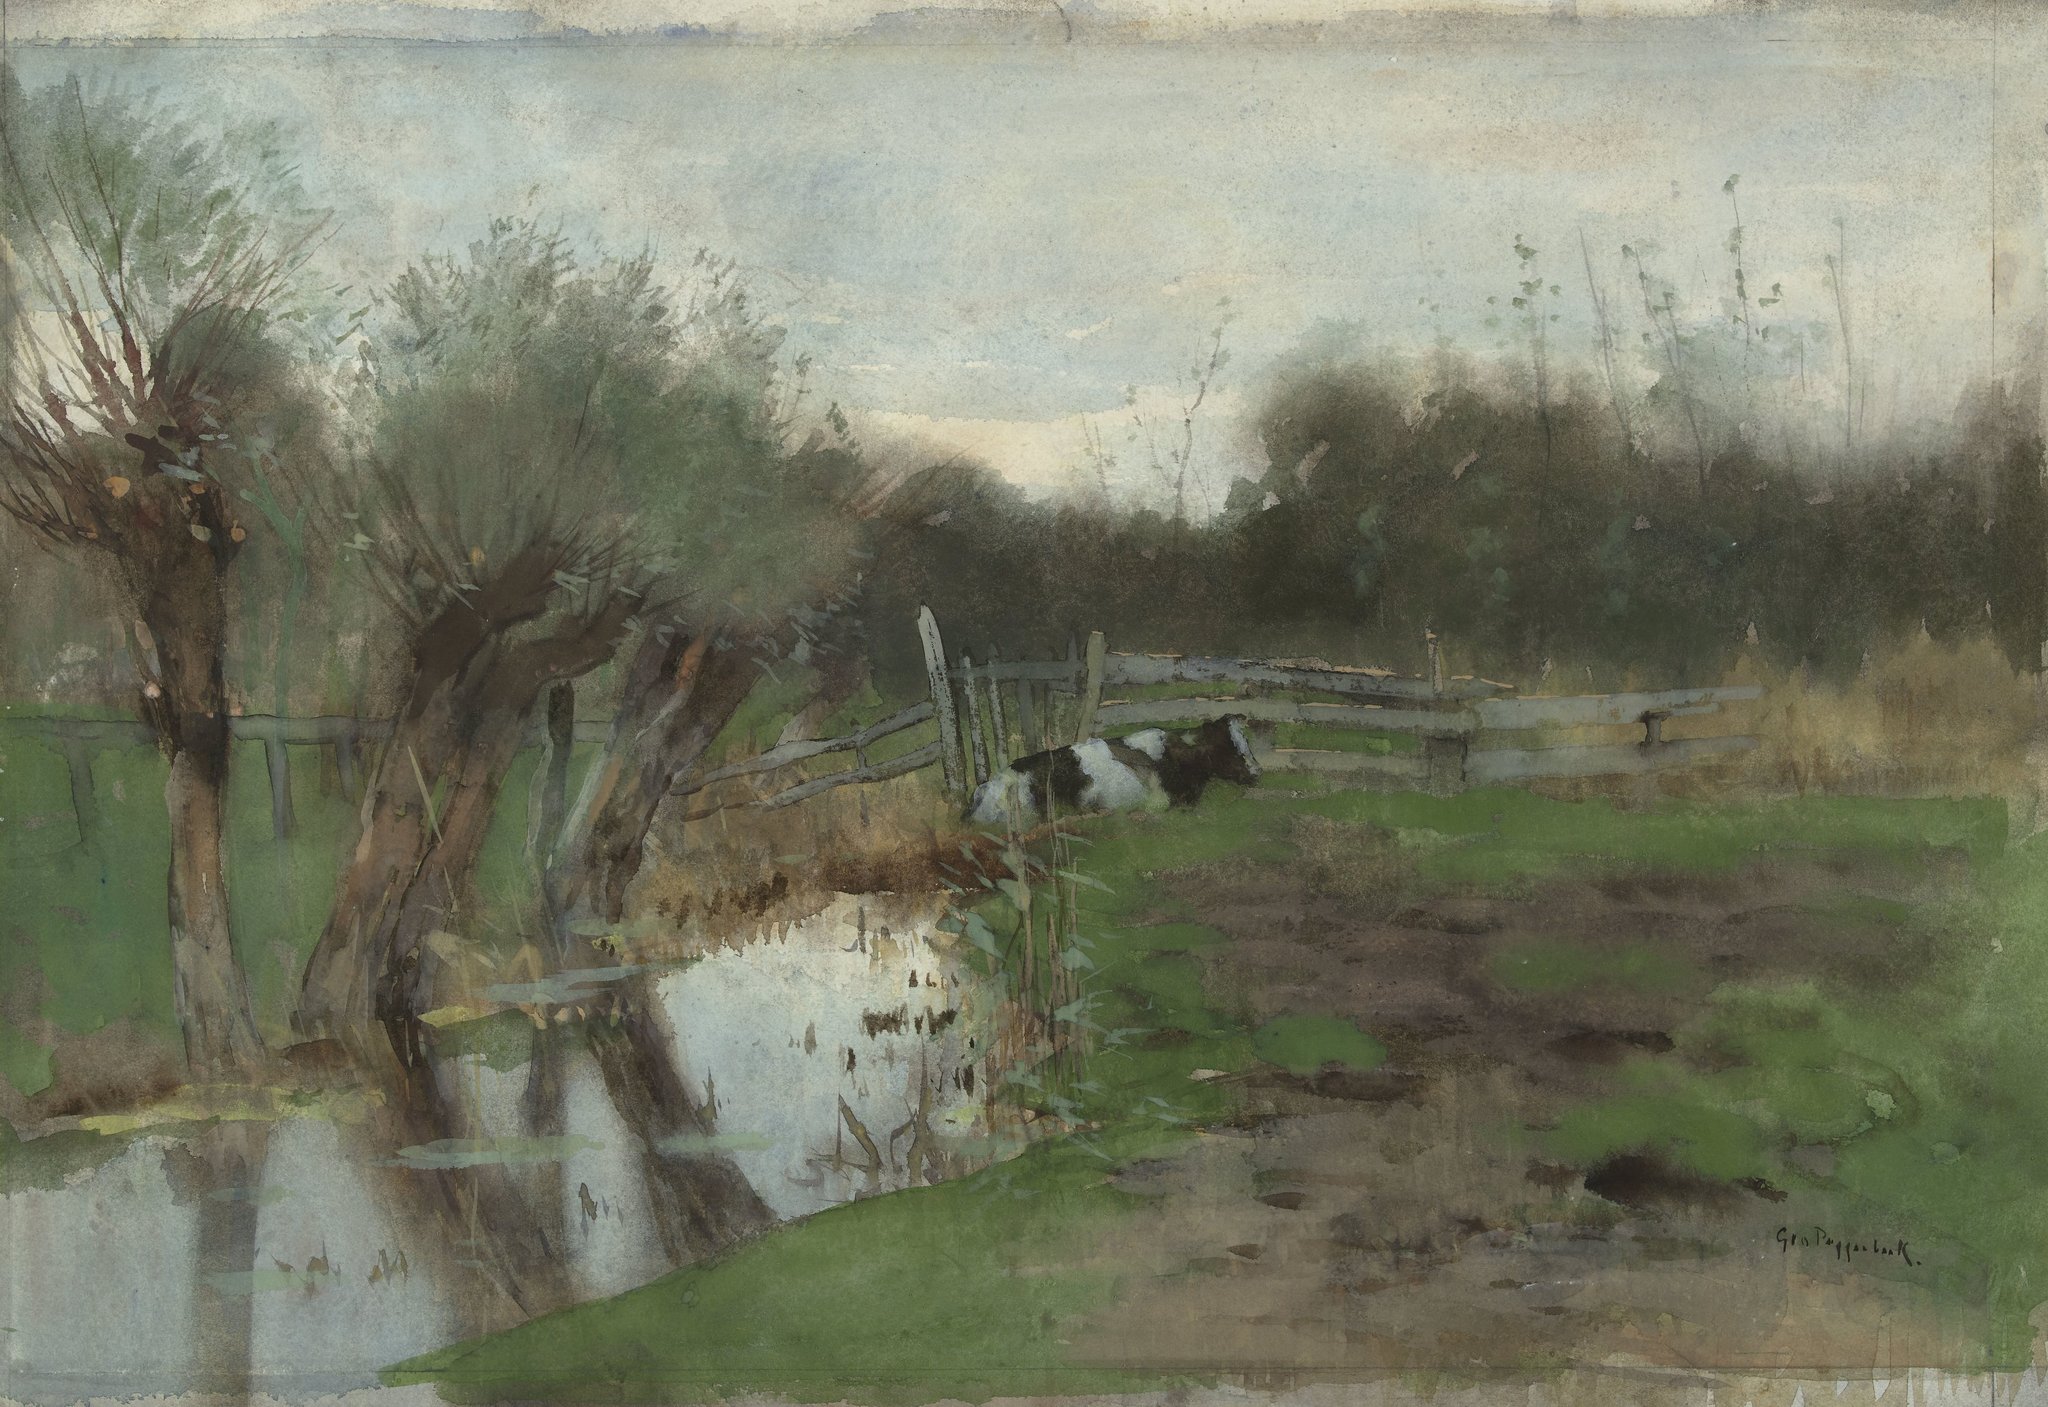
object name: watercolor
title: Weiland met liggende koe bij een sloot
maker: geo poggenbeek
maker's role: draughtsman, painter, print maker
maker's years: 1853-1903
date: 1863-1895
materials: paper, watercolor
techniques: brush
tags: cow, meadow, pasture